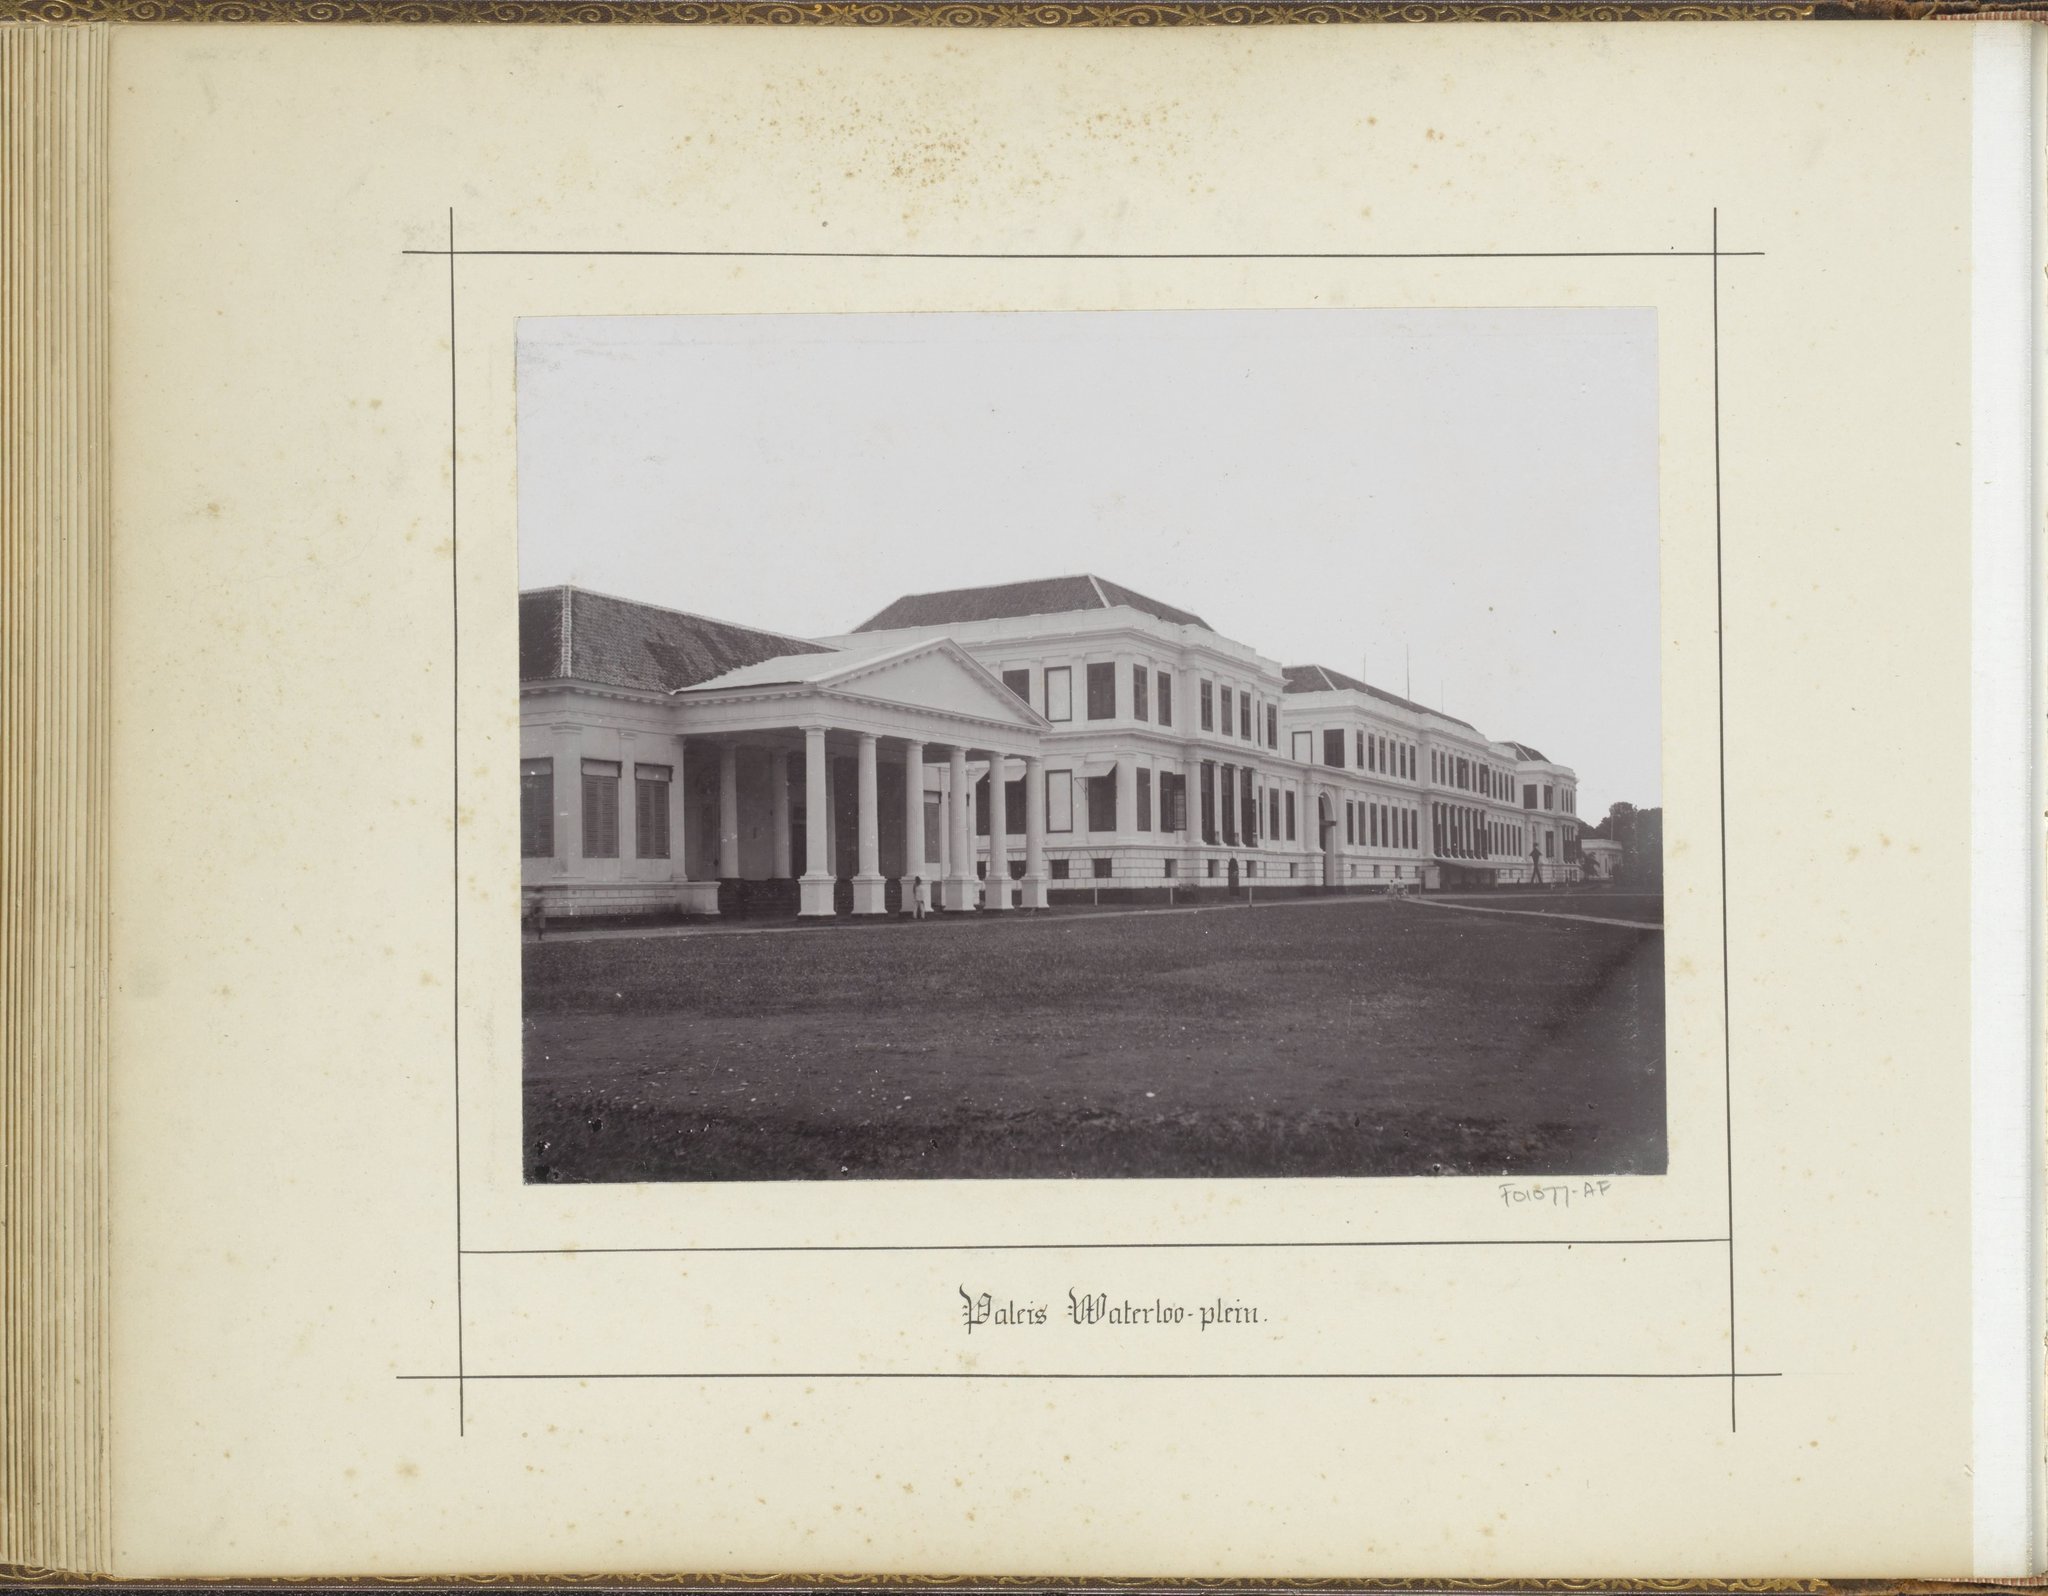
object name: album leaf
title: Exterieur van het paleis van Daendels aan het Waterlooplein in Batavia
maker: Anonymous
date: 1890-1910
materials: cardboard, photographic support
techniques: collodion silver print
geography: batavia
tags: palace, batavia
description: Onderdeel van Album met foto's van Batavia en van de zusters Ursulinen.